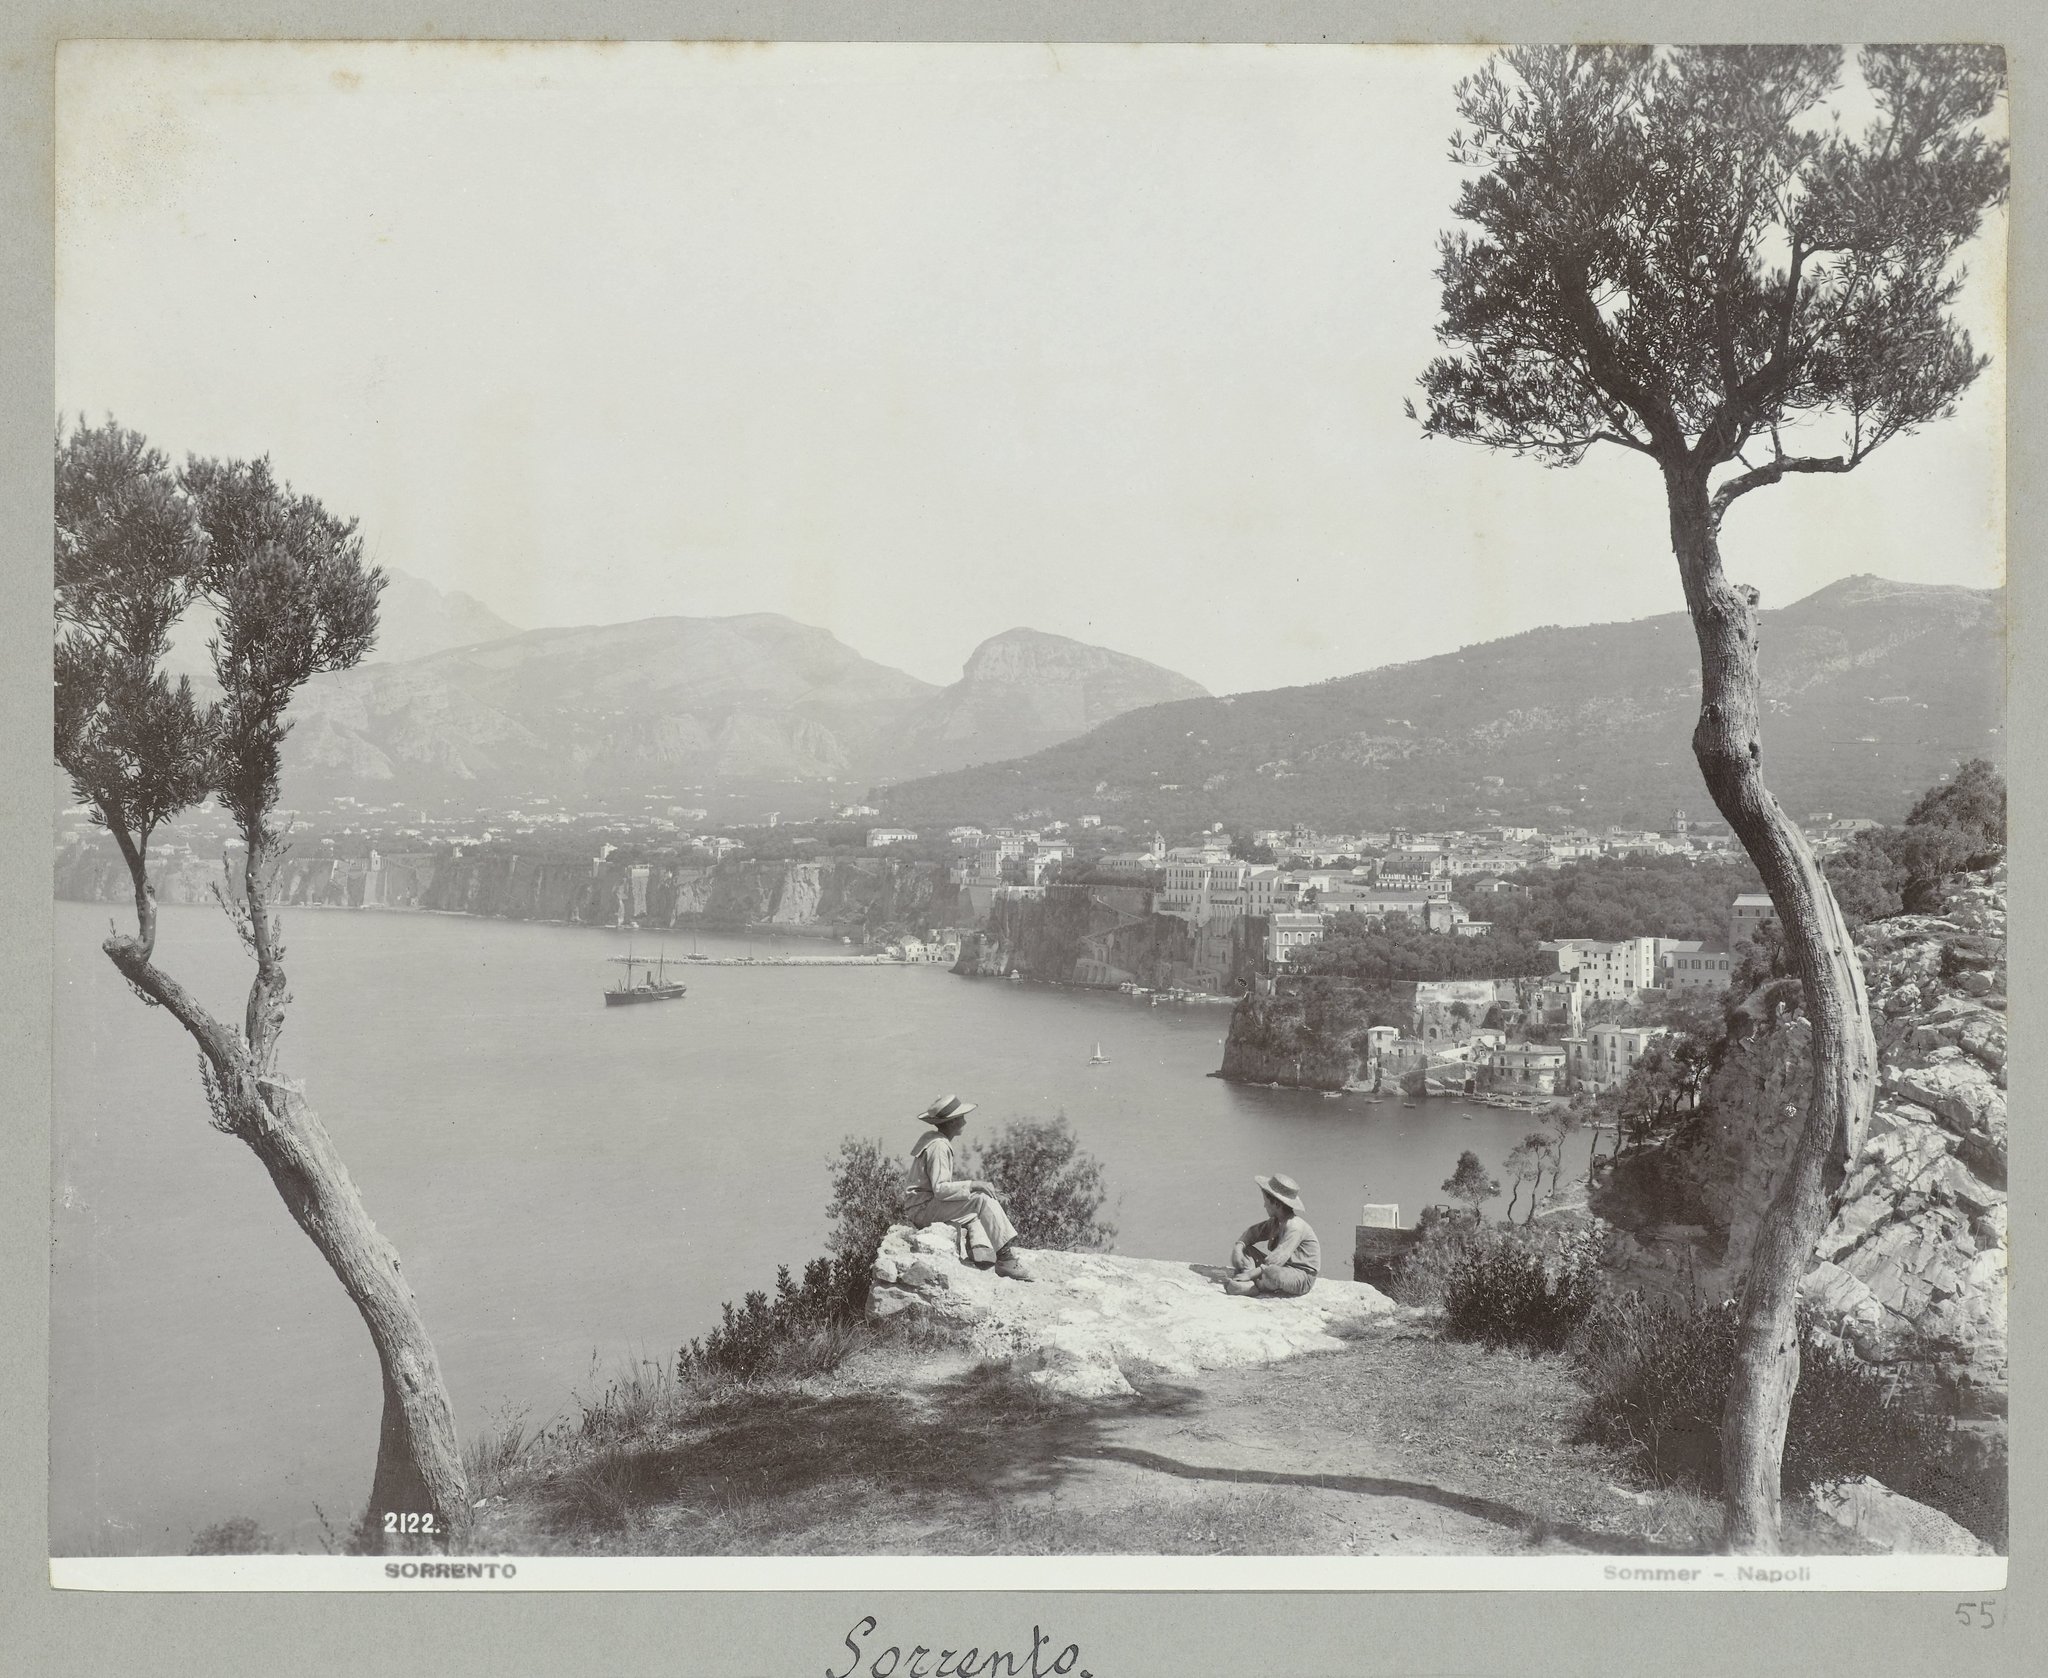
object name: photograph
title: Sorrento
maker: giorgio sommer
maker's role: fotograaf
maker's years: 1834-1914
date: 1888-1903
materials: cardboard, photographic support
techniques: albumen print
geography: netherlands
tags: sorrento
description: Stadspanorama langs de kust van het het aan de Amalfische kust gelegen stadje Sorrento met op de achtregrond een berglandschap.